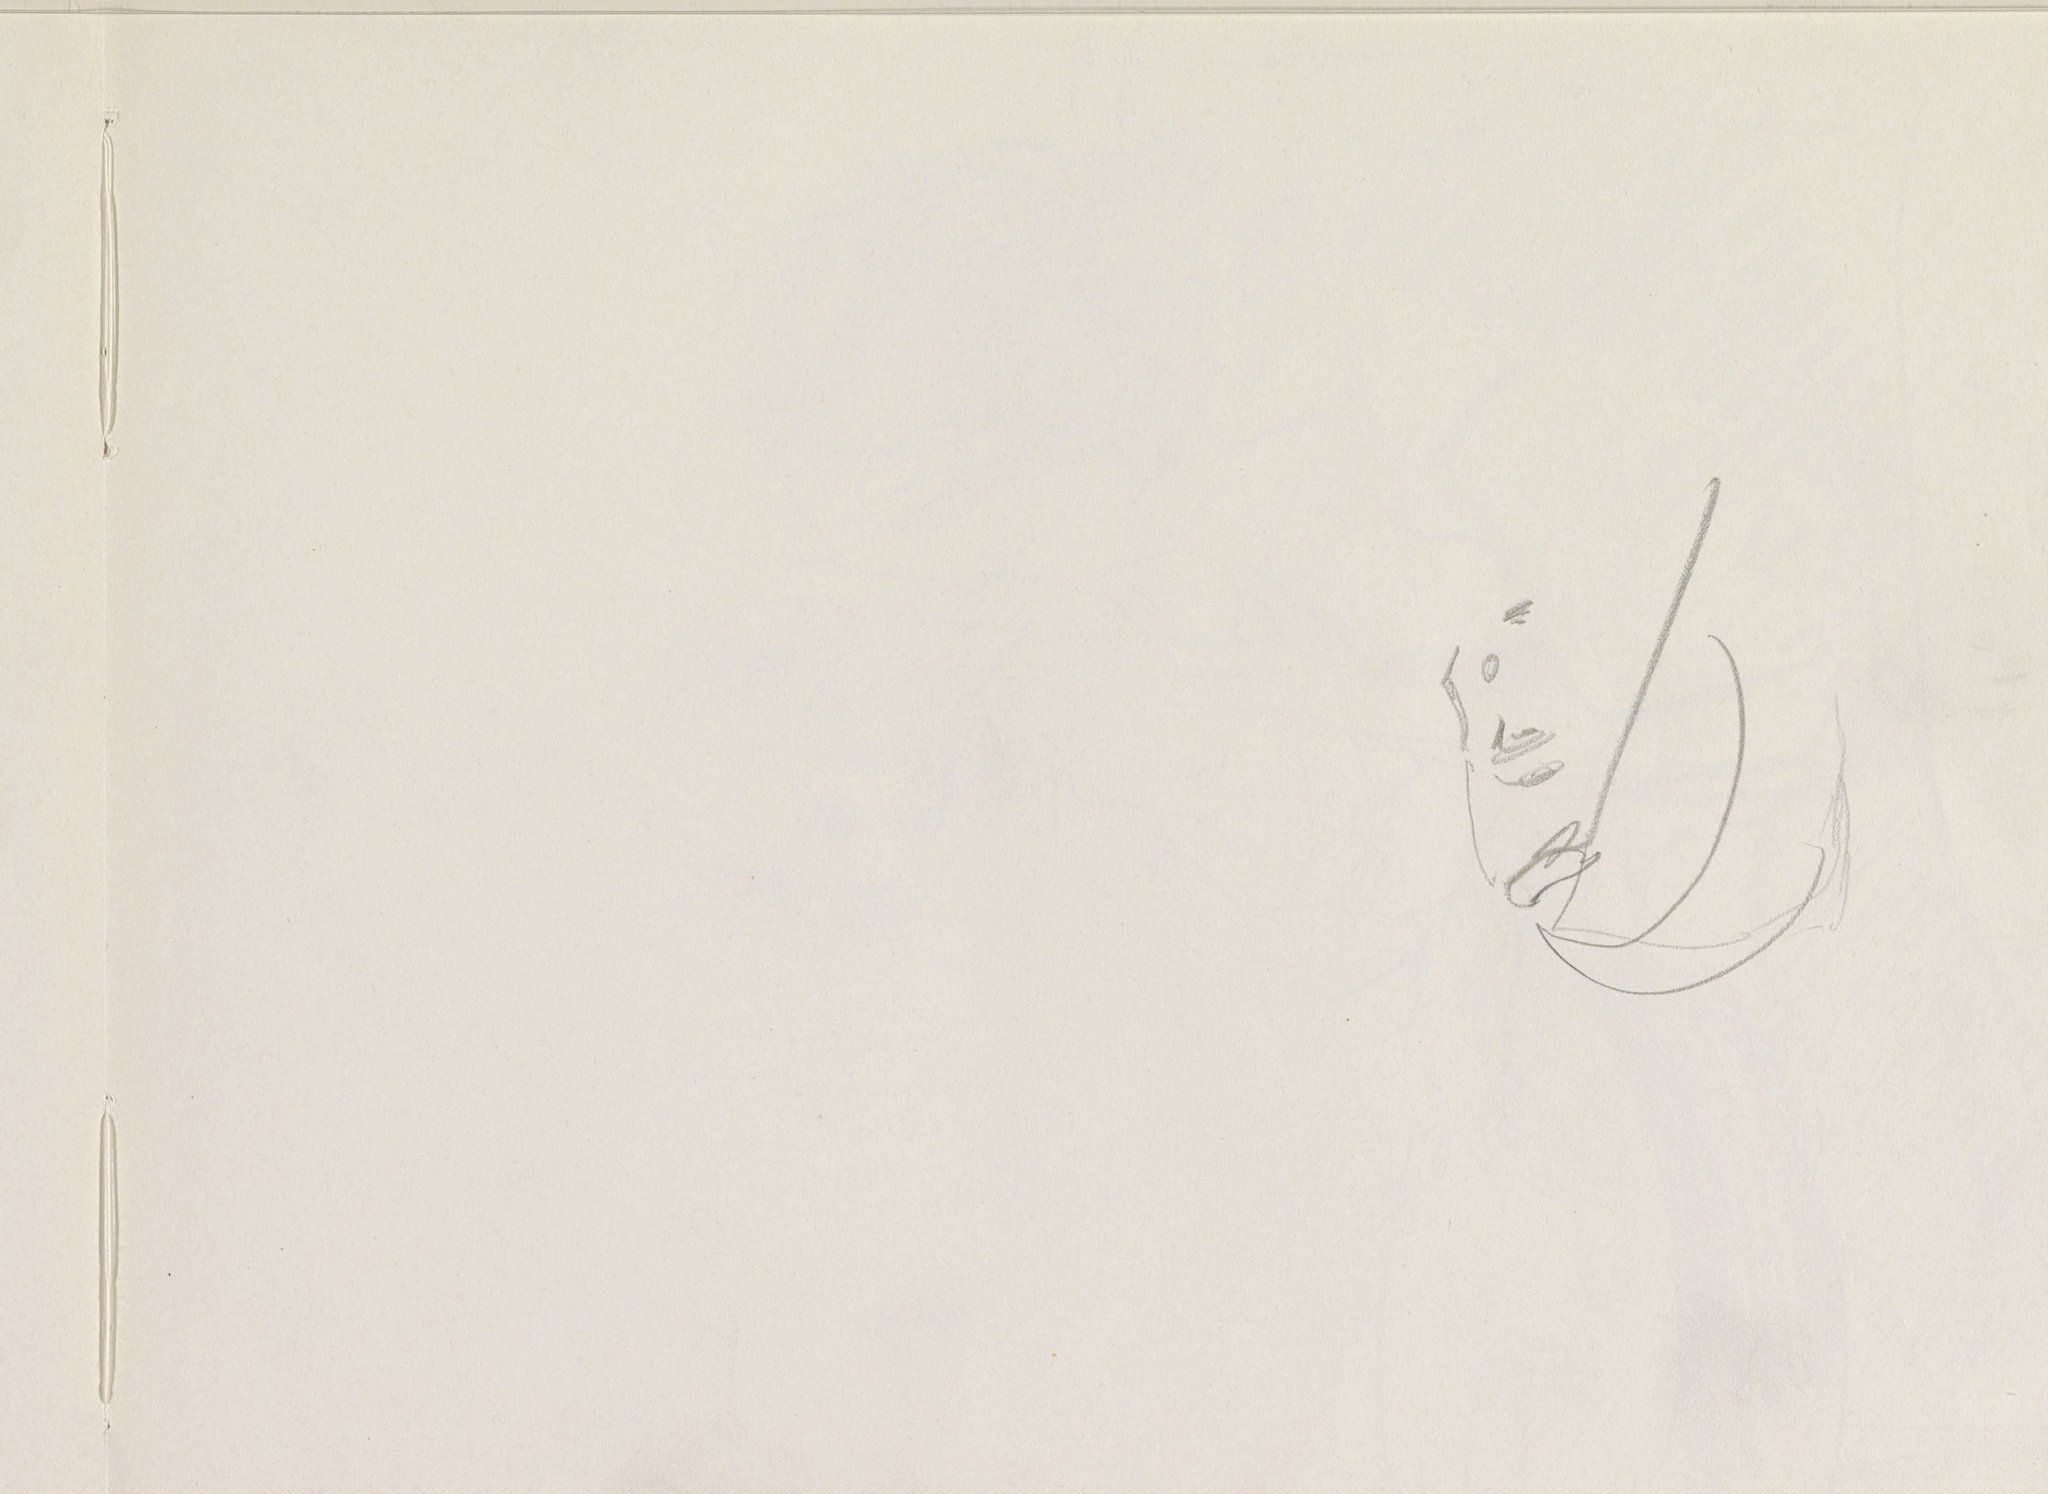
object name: sketchbook leaf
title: Gezicht van een jonge vrouw, in profiel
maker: isaac israels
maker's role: draughtsman, painter, print maker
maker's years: 1865-1934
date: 1915-1934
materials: paper, pencil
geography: the hague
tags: adolescent, young woman, maiden, face (+ sideview, profile)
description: Blad 5 recto uit schetsboek III met 36 bladen.